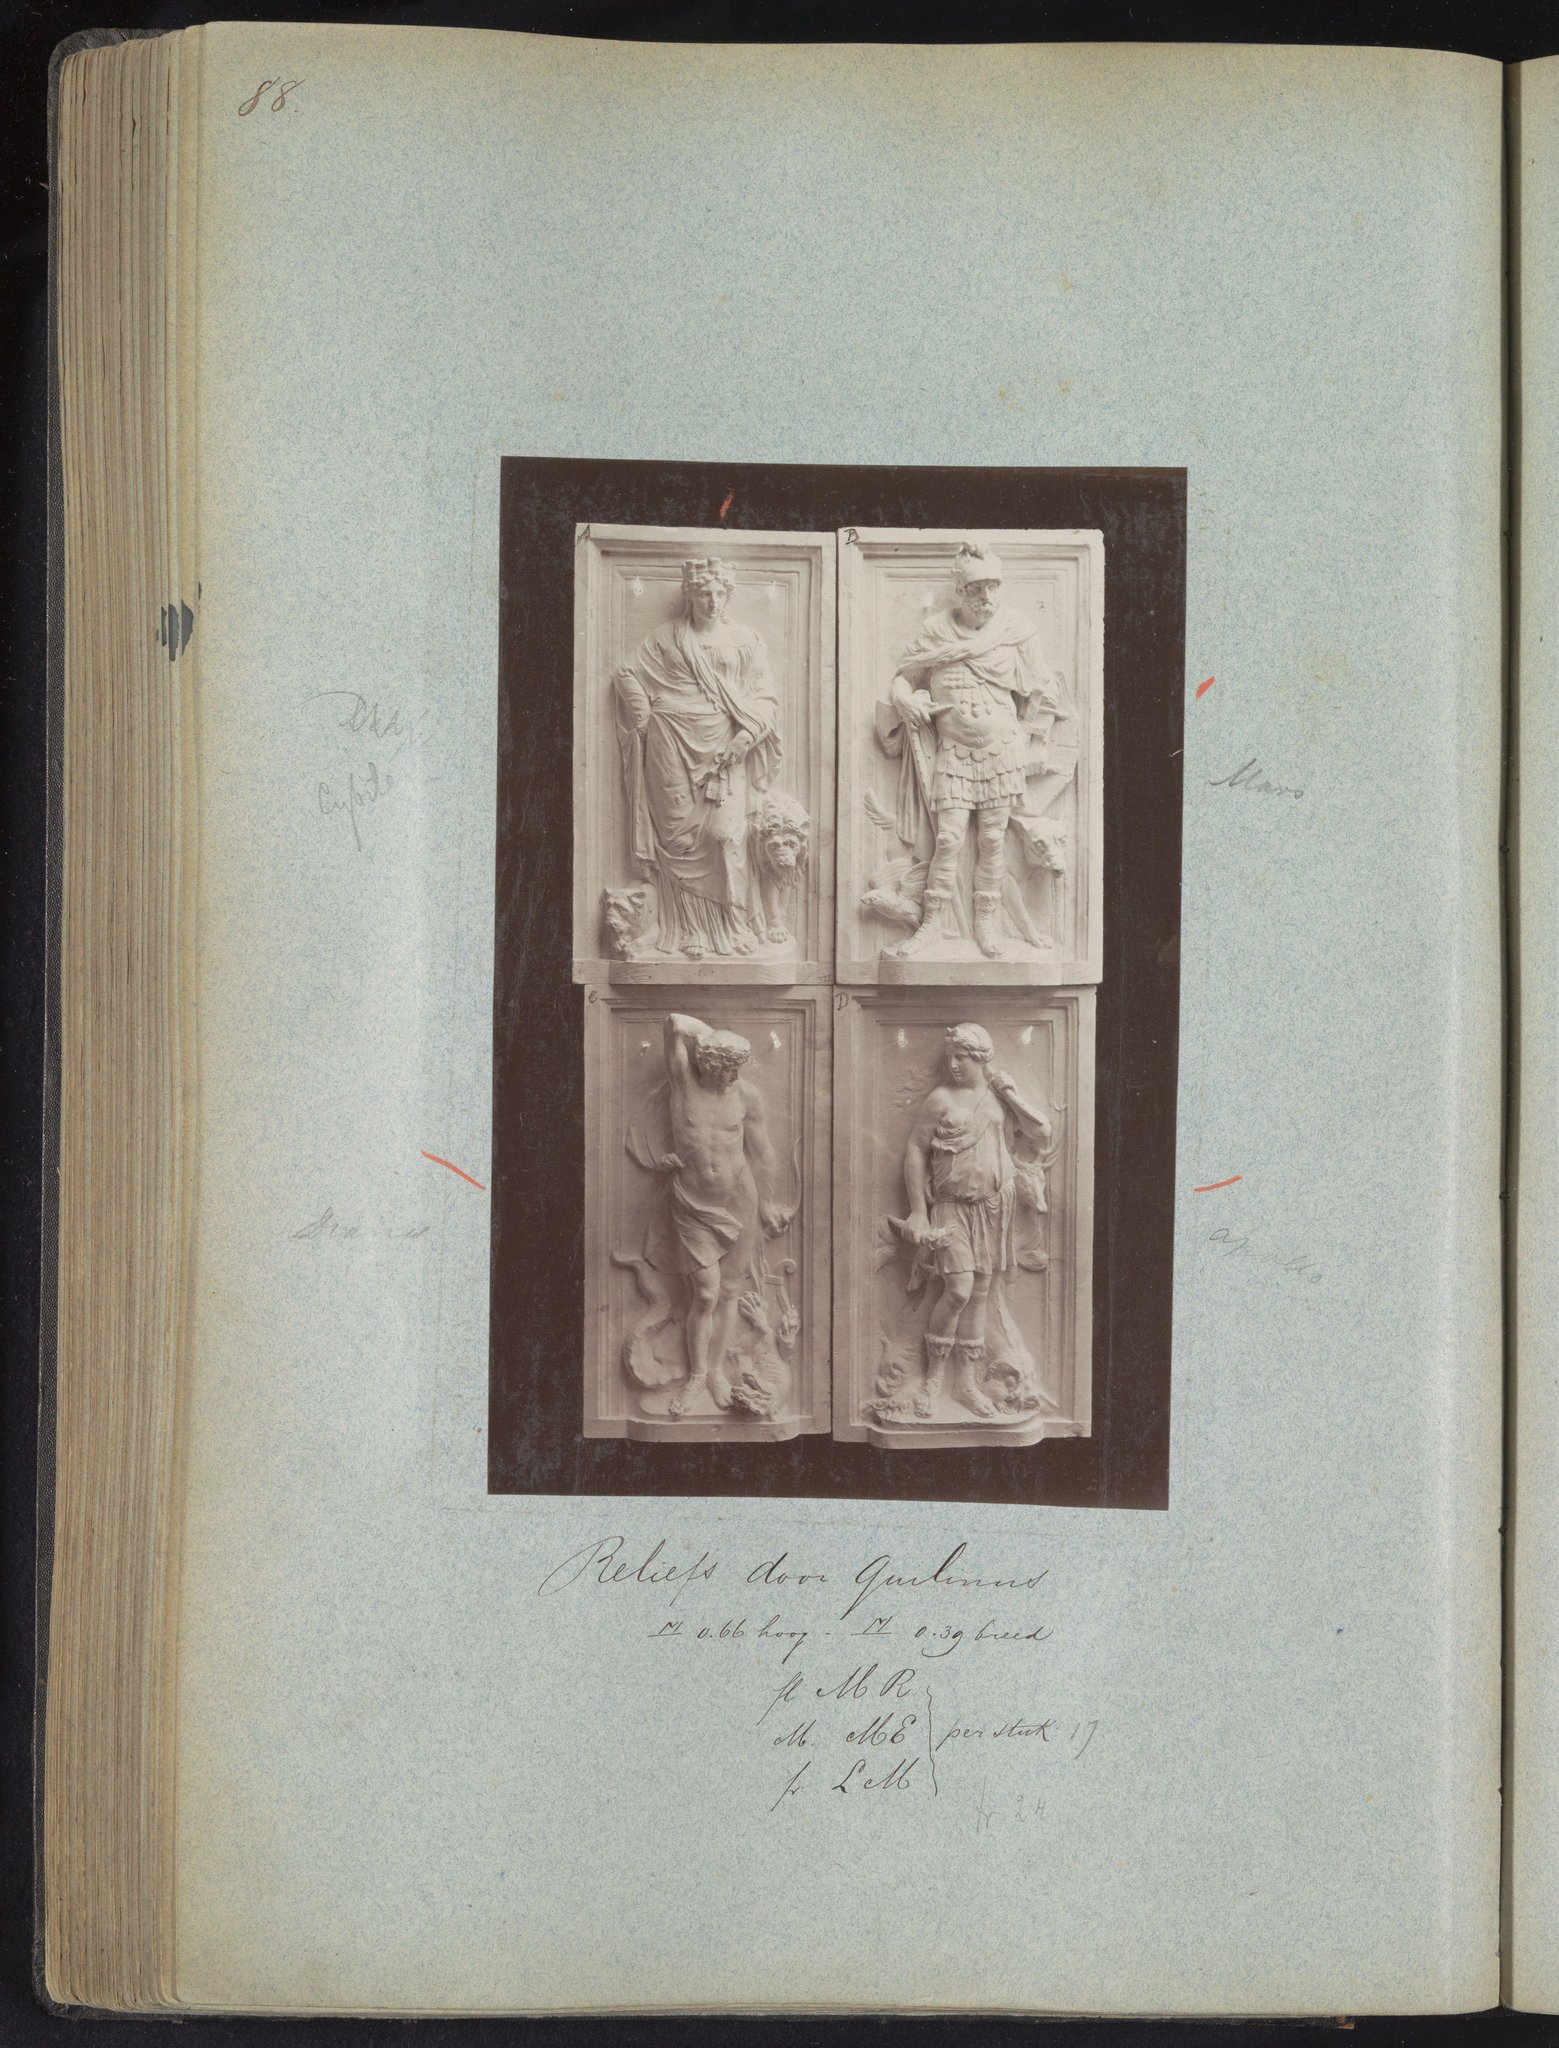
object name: album leaf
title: Vier gipsen afgietsels van reliëfs door Quellinus, vermoedelijk voorstellende Cybele, Mars, Diana en Apollo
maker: Anonymous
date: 1875-1900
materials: paper, photographic support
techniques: albumen print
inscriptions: annotation: ‘Reliëfs door Quilinus / M 0.66 hoog - M 0.39 breed’, annotation, annotation: ‘Cybille / Mars / Diana / Apollo’